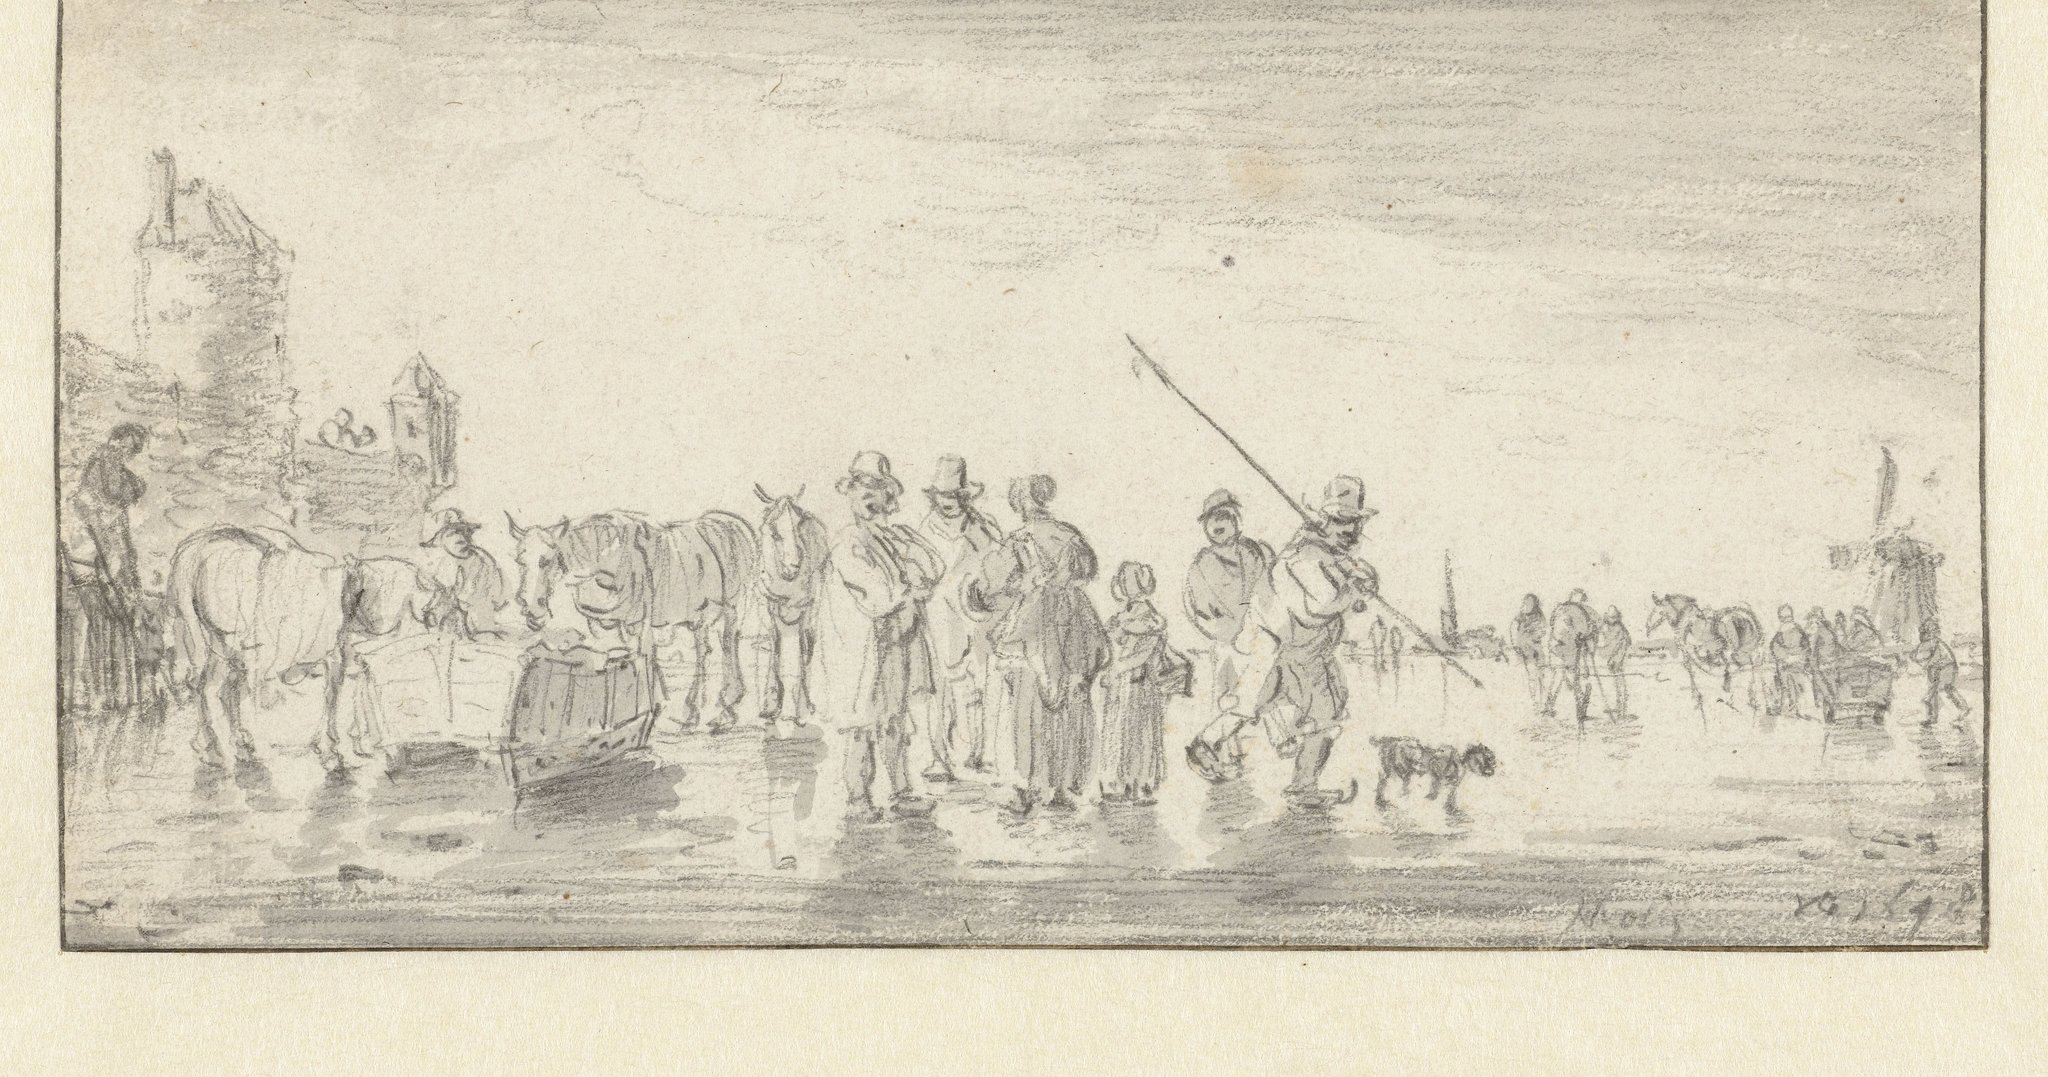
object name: drawing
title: IJsvermaak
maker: jan van goyen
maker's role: draughtsman, painter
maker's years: 1596-1656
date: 1648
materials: chalk, paper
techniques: brush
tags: winter sports, ice ~ freezing weather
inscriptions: date: ‘1648’